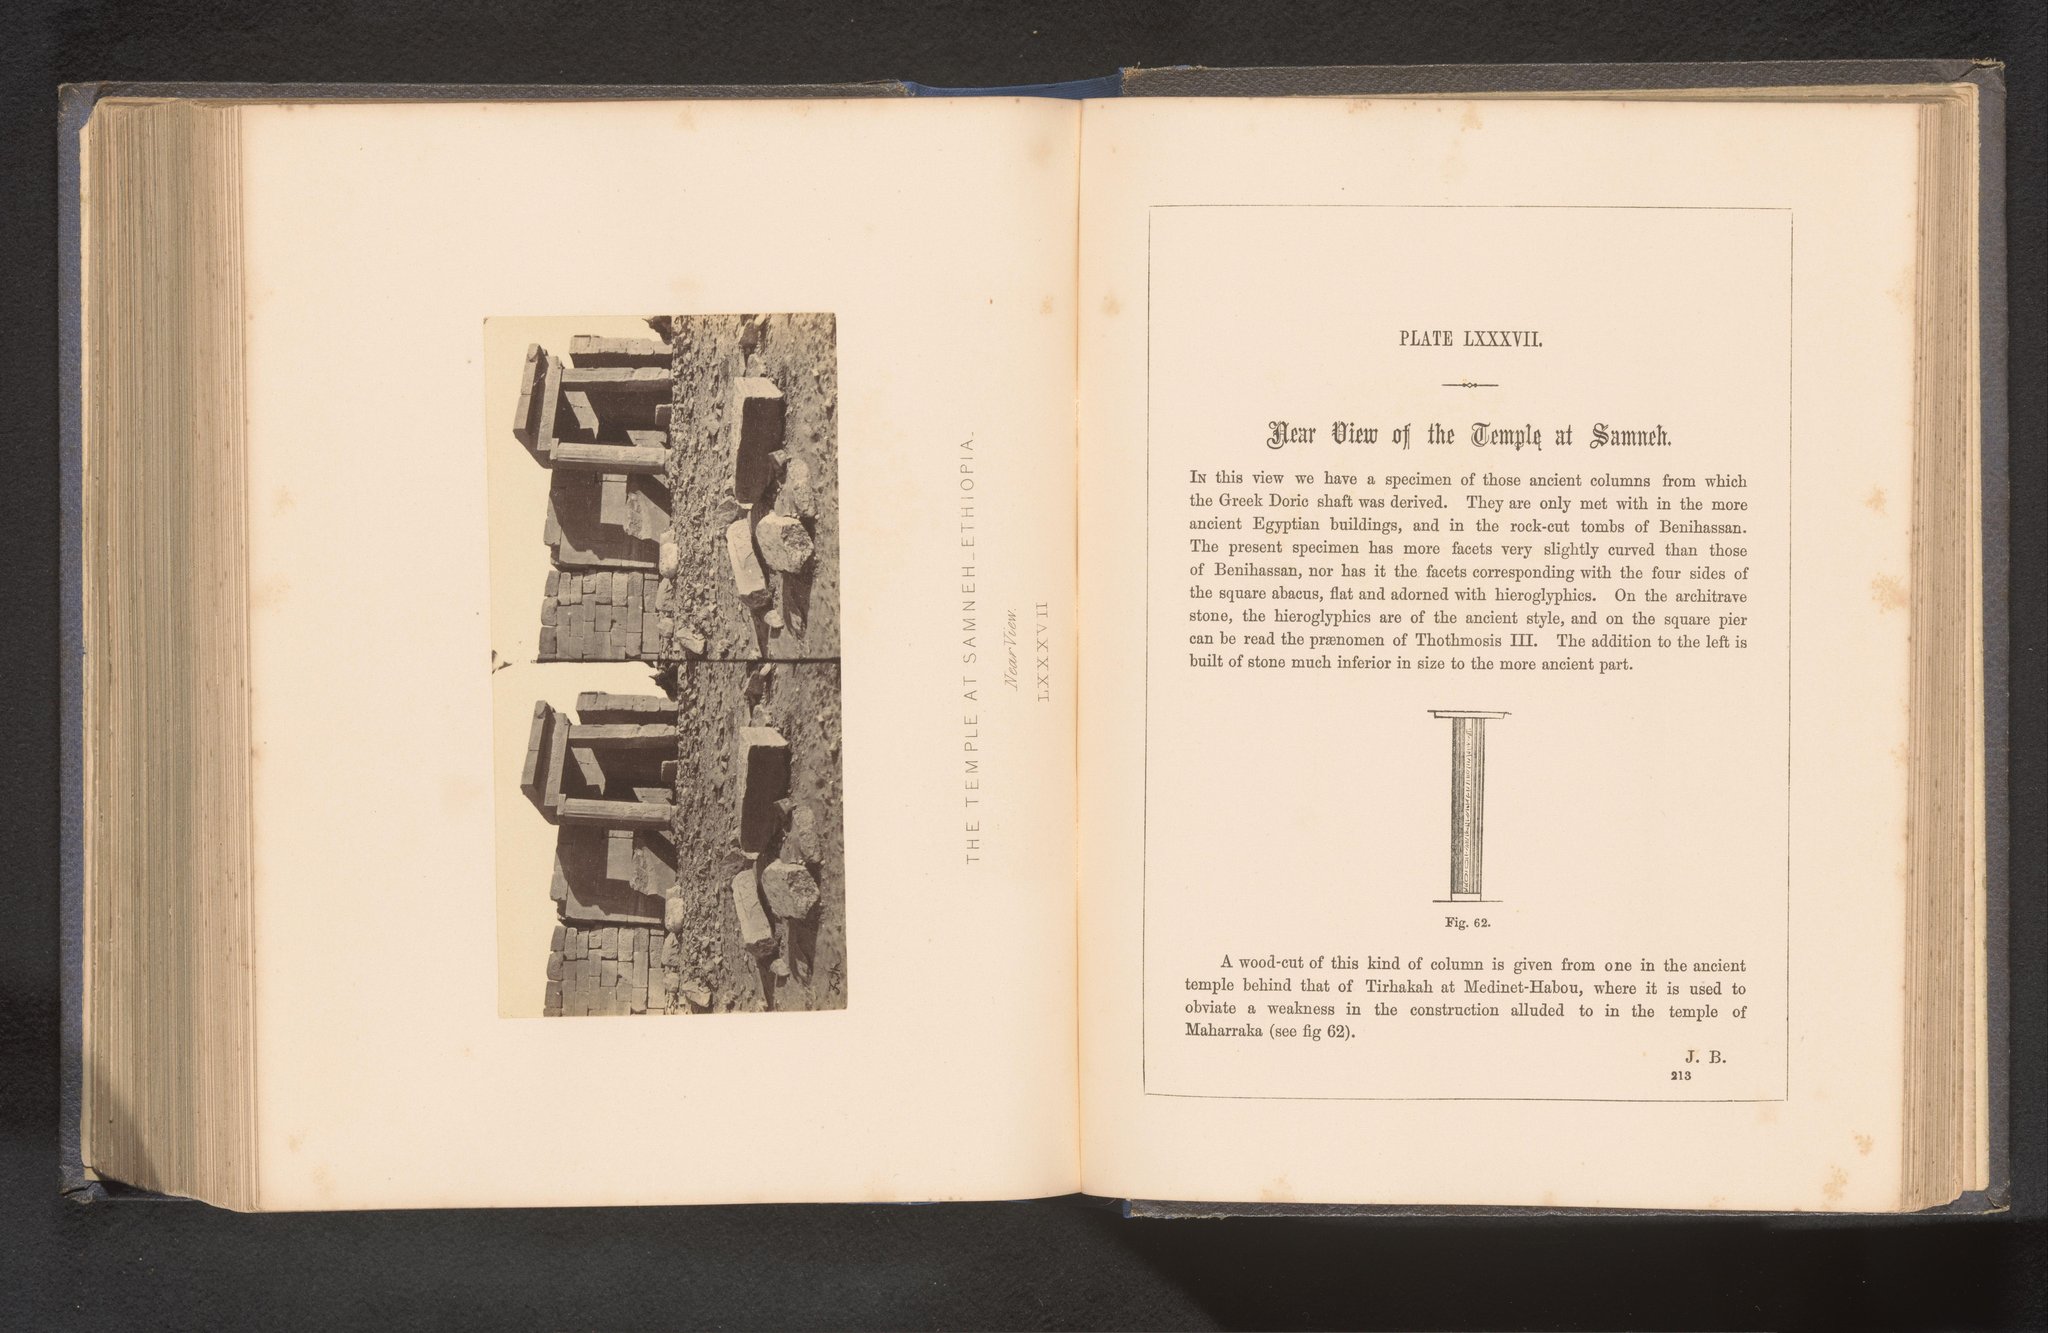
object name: page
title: Tempel te Semna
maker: francis frith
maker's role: publisher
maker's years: 1822-1898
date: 1857-1862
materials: photographic support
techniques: albumen print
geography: semna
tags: temple, shrine ~ egyptian religion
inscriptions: number: ‘LXXXVII’, name: ‘Frith’, inscription: ‘Near View’